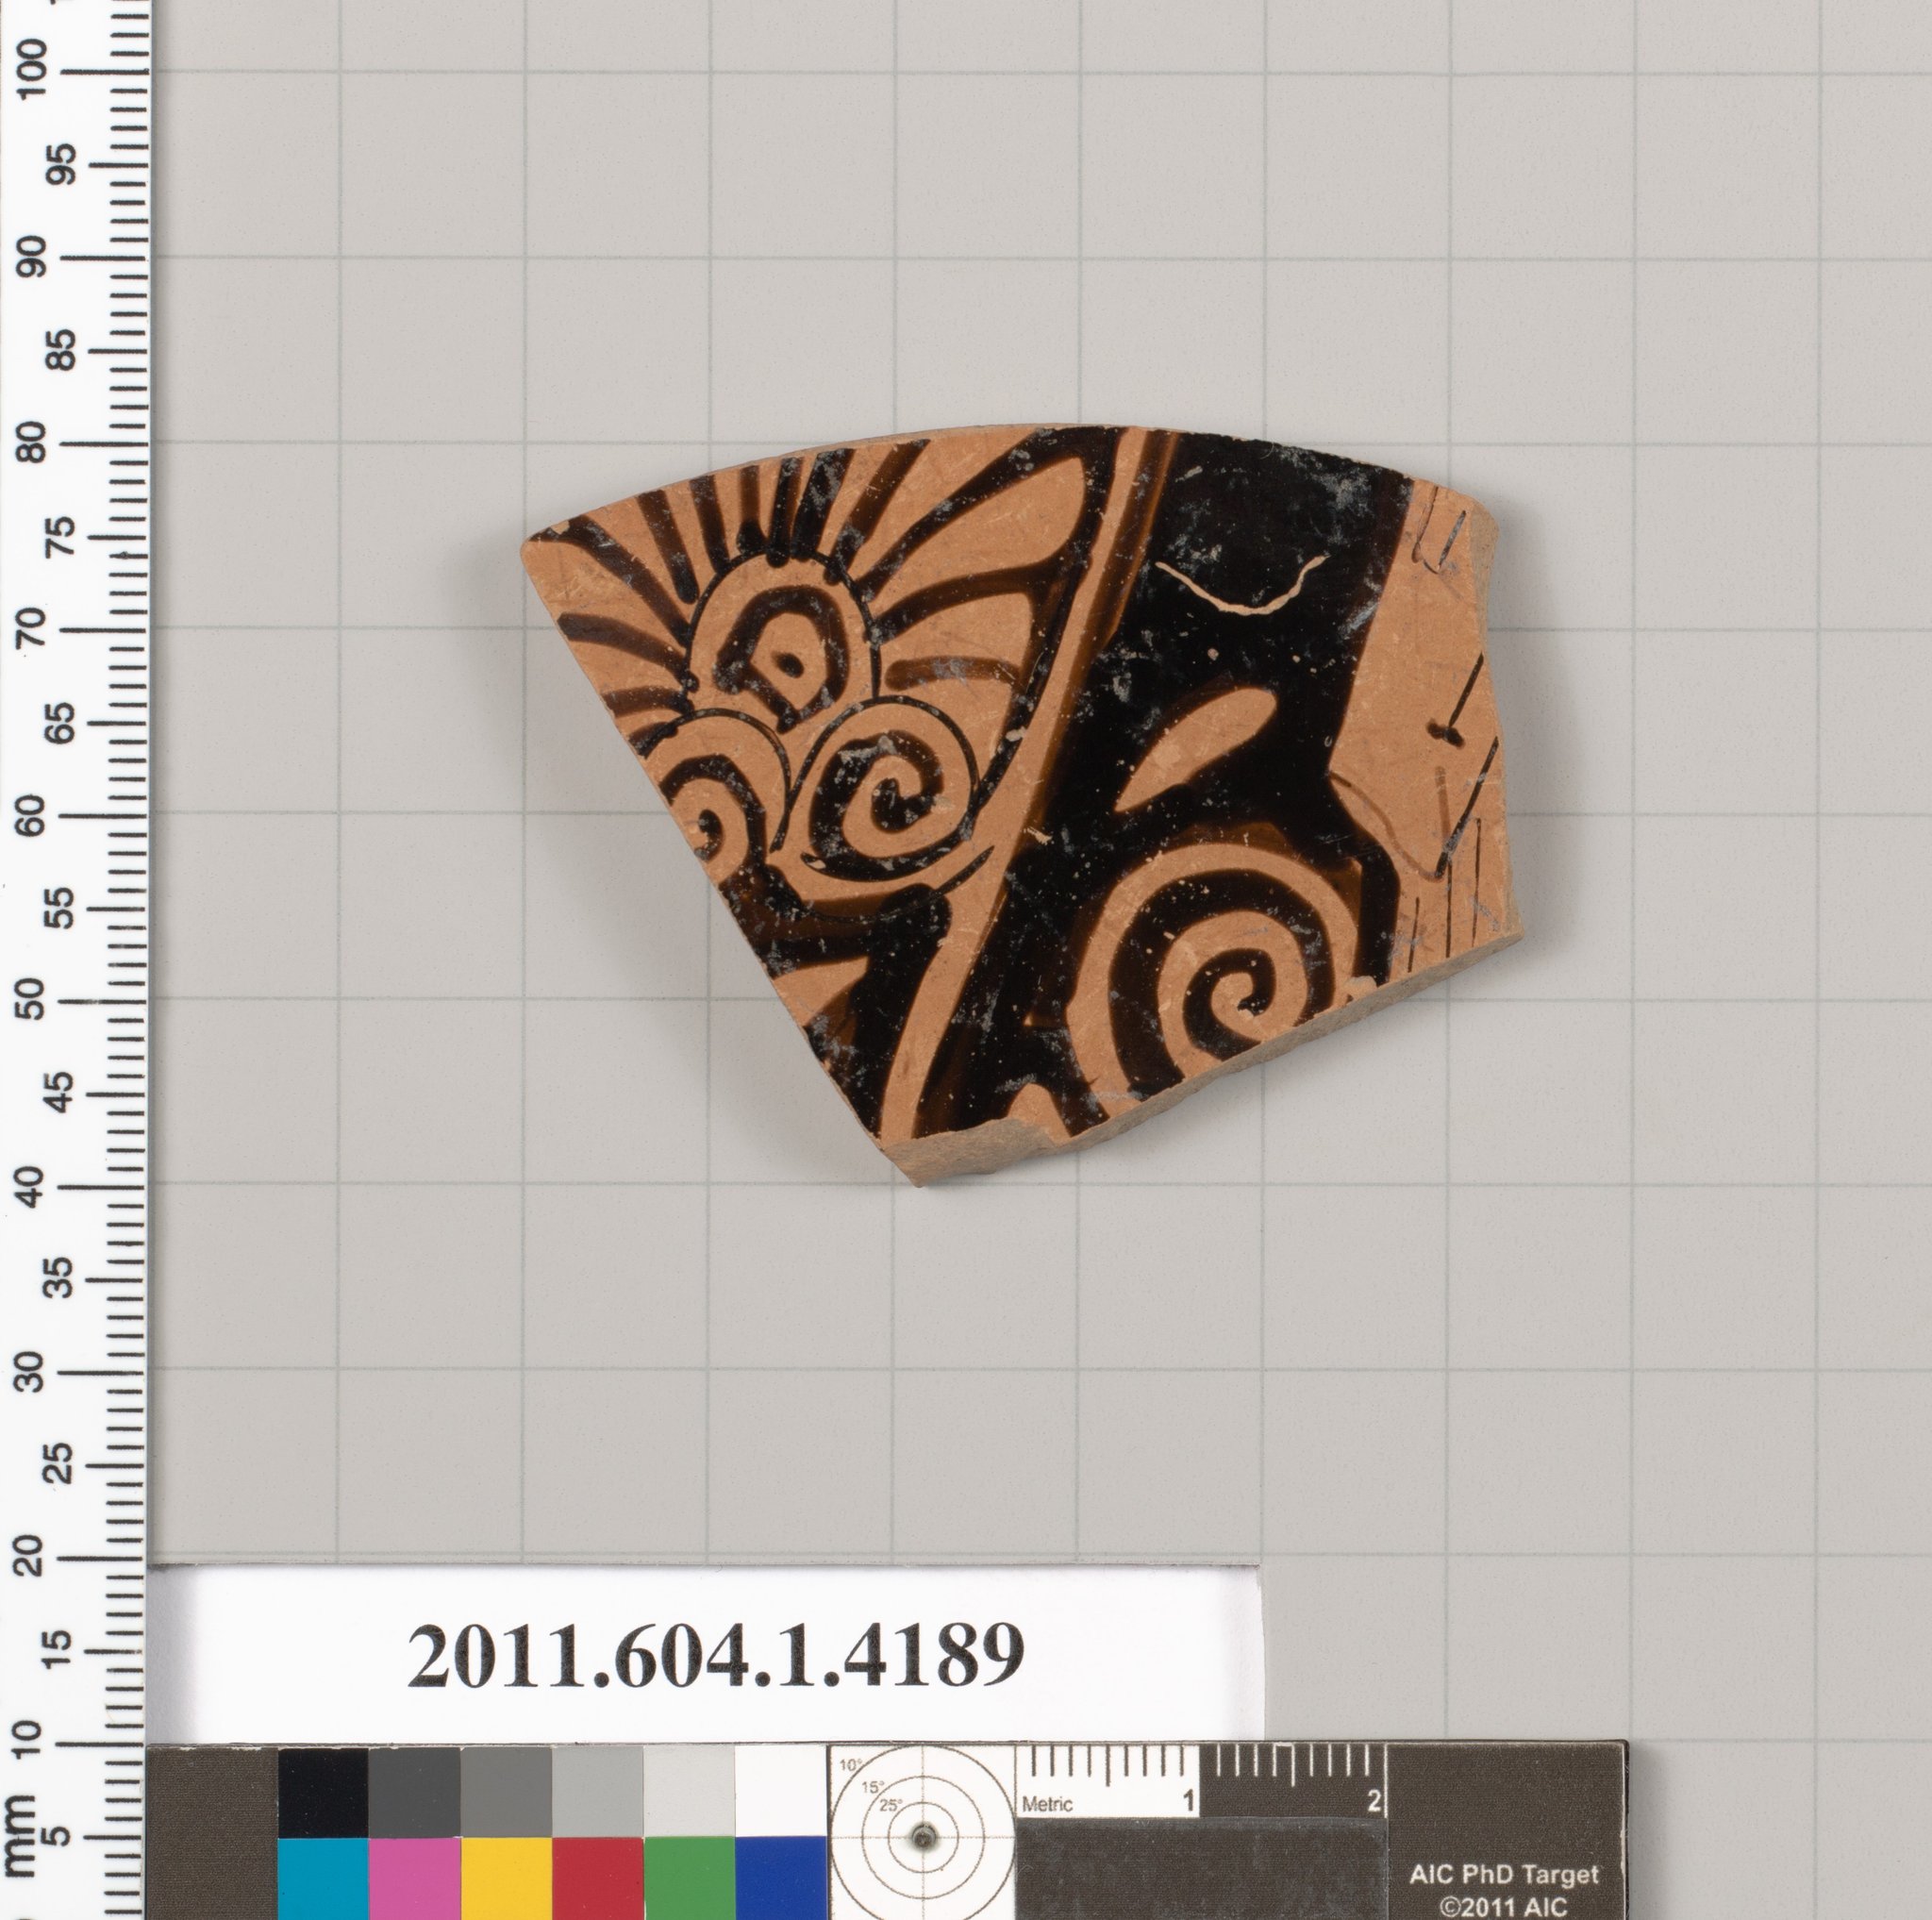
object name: kylix fragment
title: Terracotta fragment of a kylix (drinking cup)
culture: greek, attic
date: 475-451 BCE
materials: terracotta